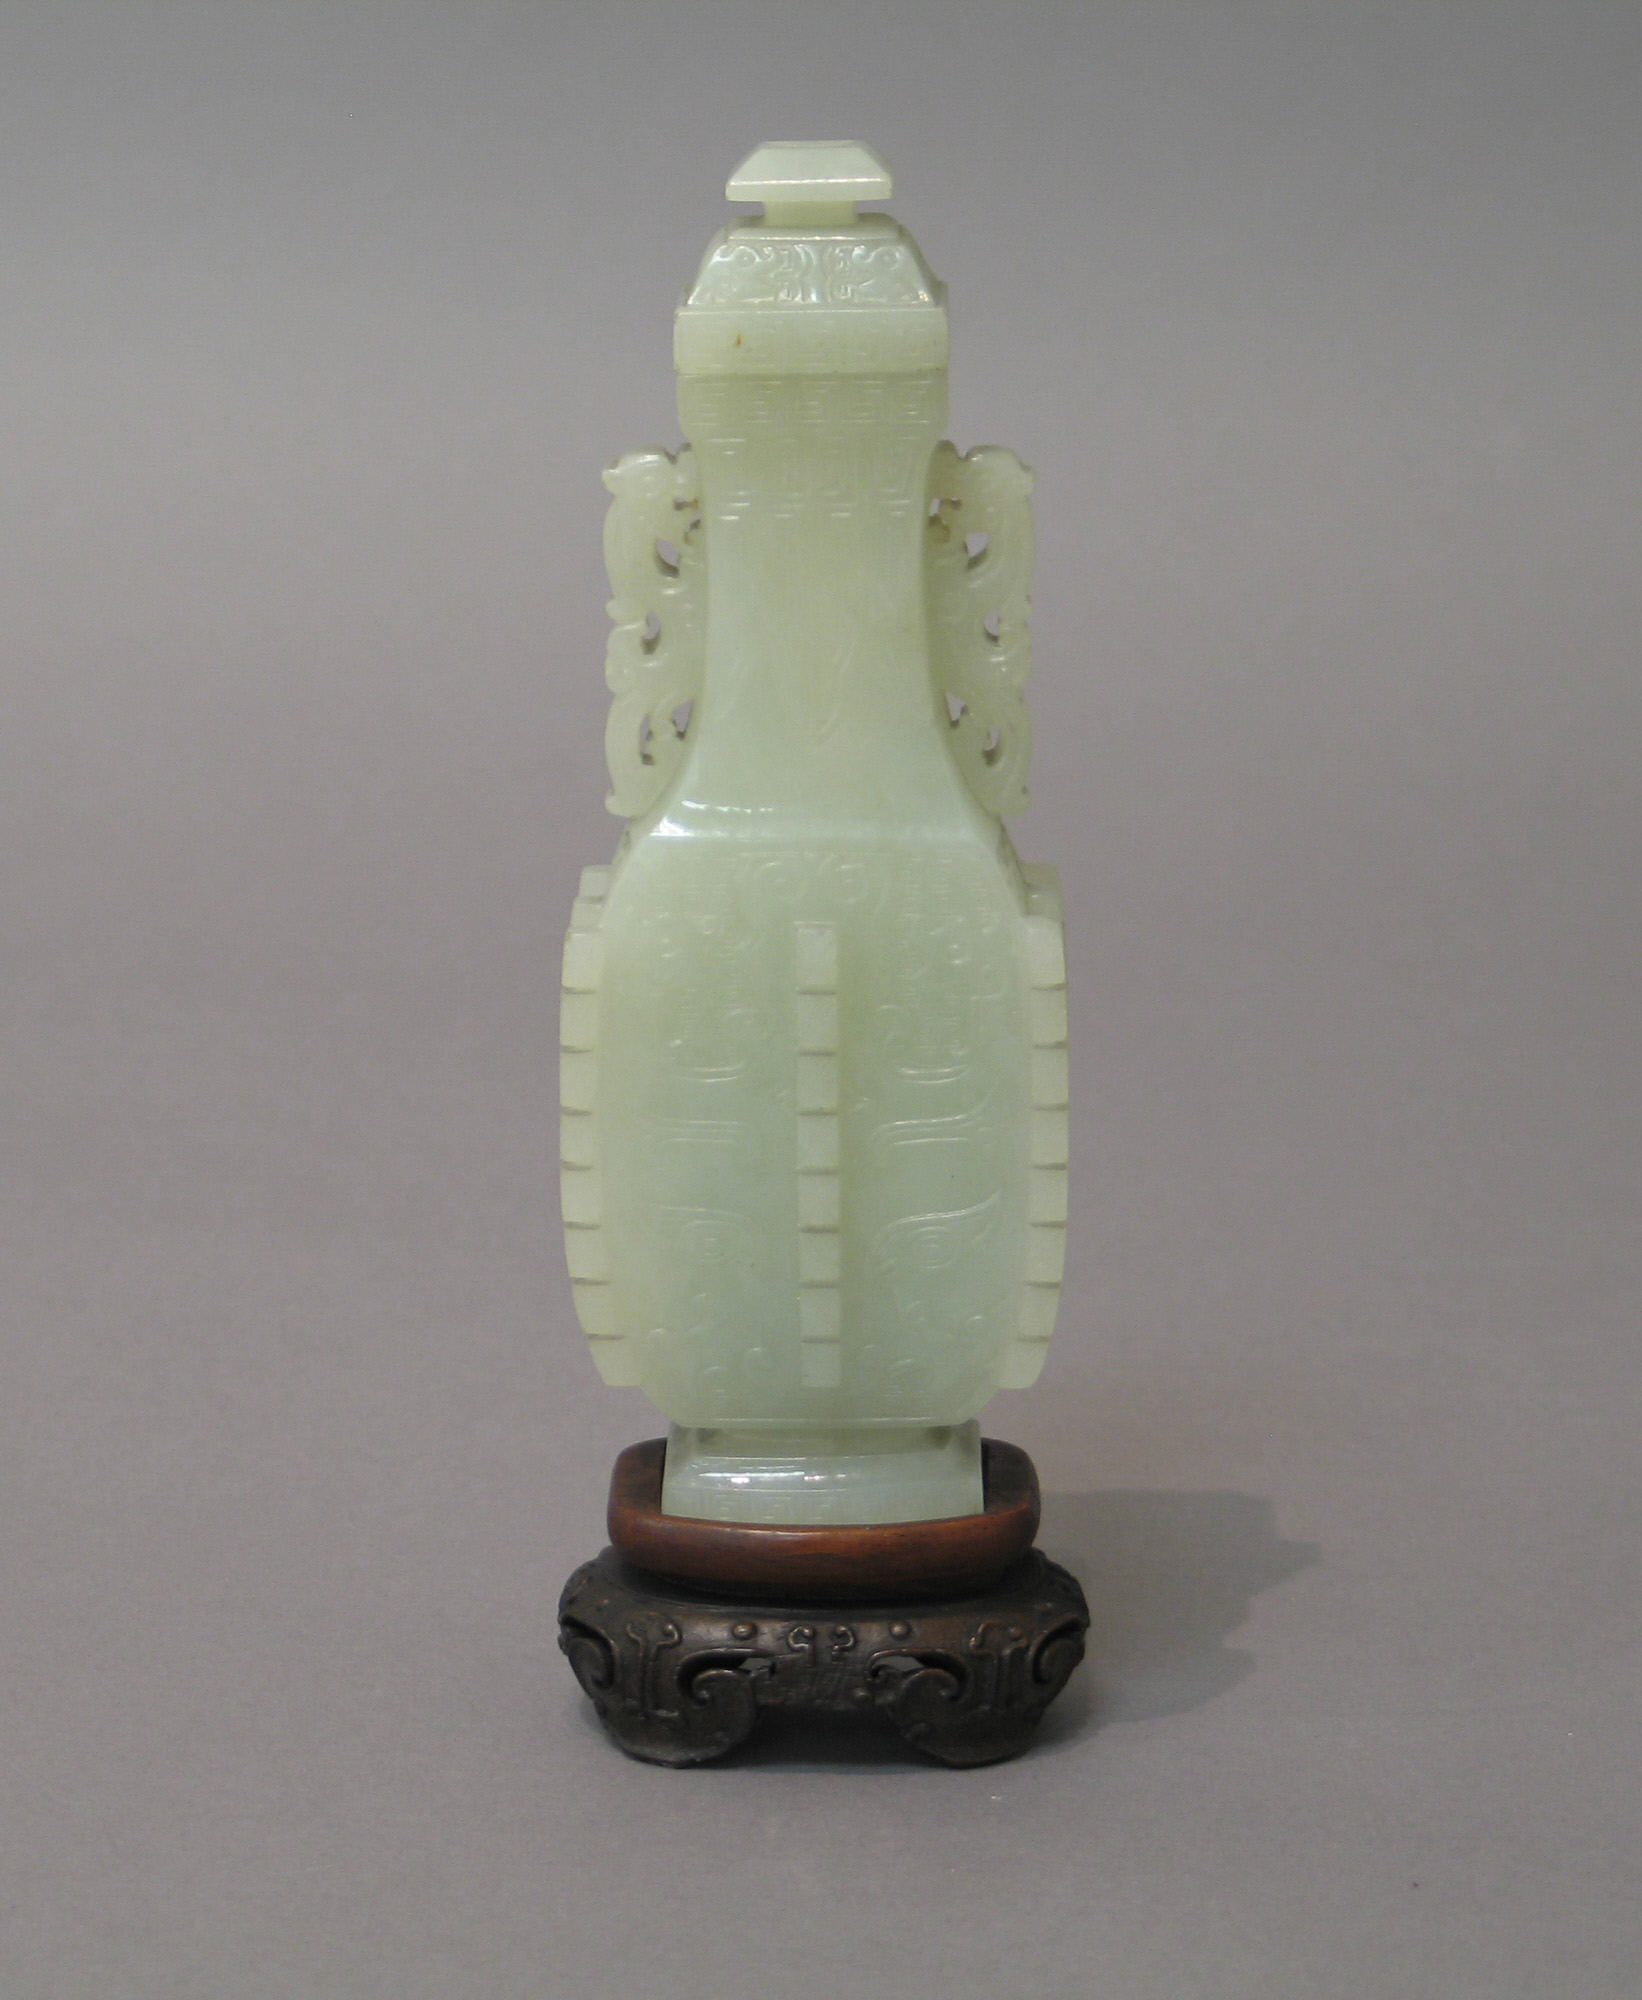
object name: vase with cover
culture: chinese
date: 1736-1795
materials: jade